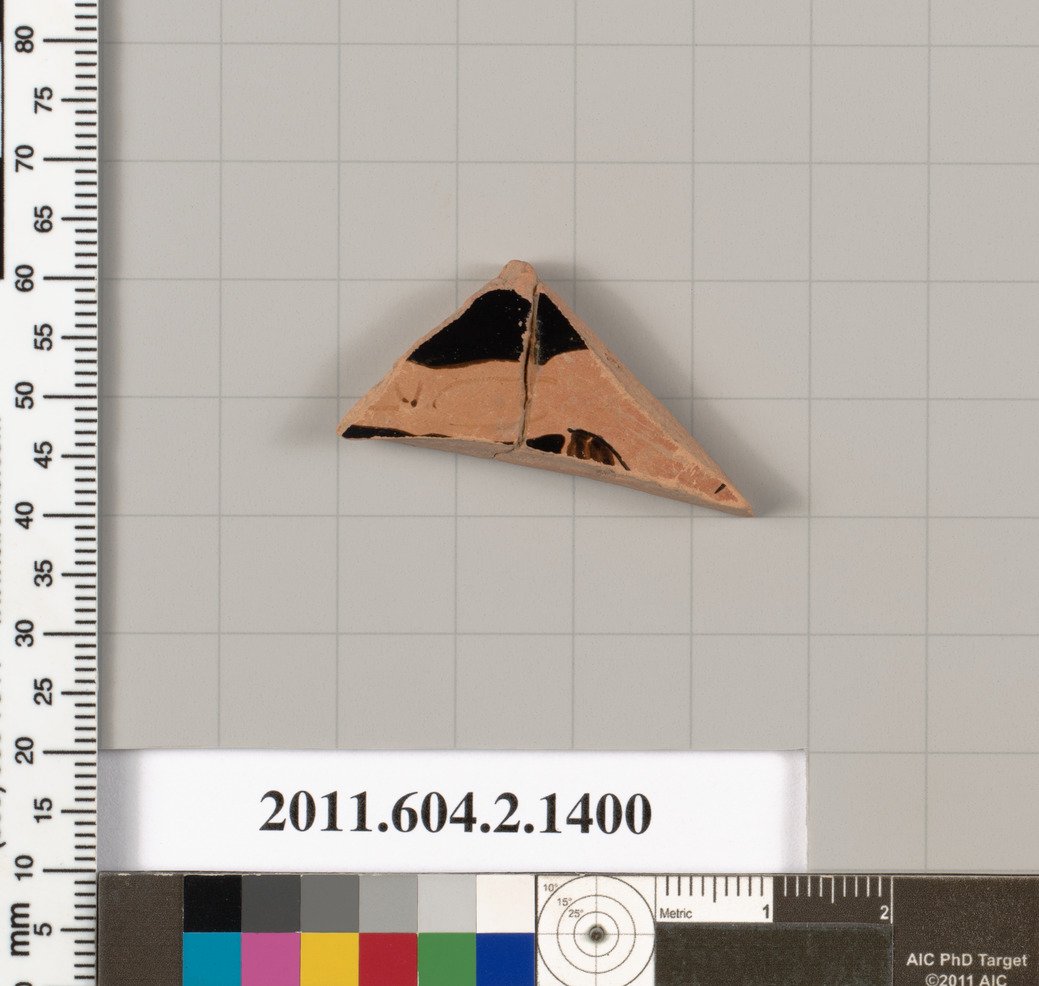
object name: skyphos fragment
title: Terracotta fragment of a skyphos (deep drinking cup)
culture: greek, attic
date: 475-451 BCE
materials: terracotta